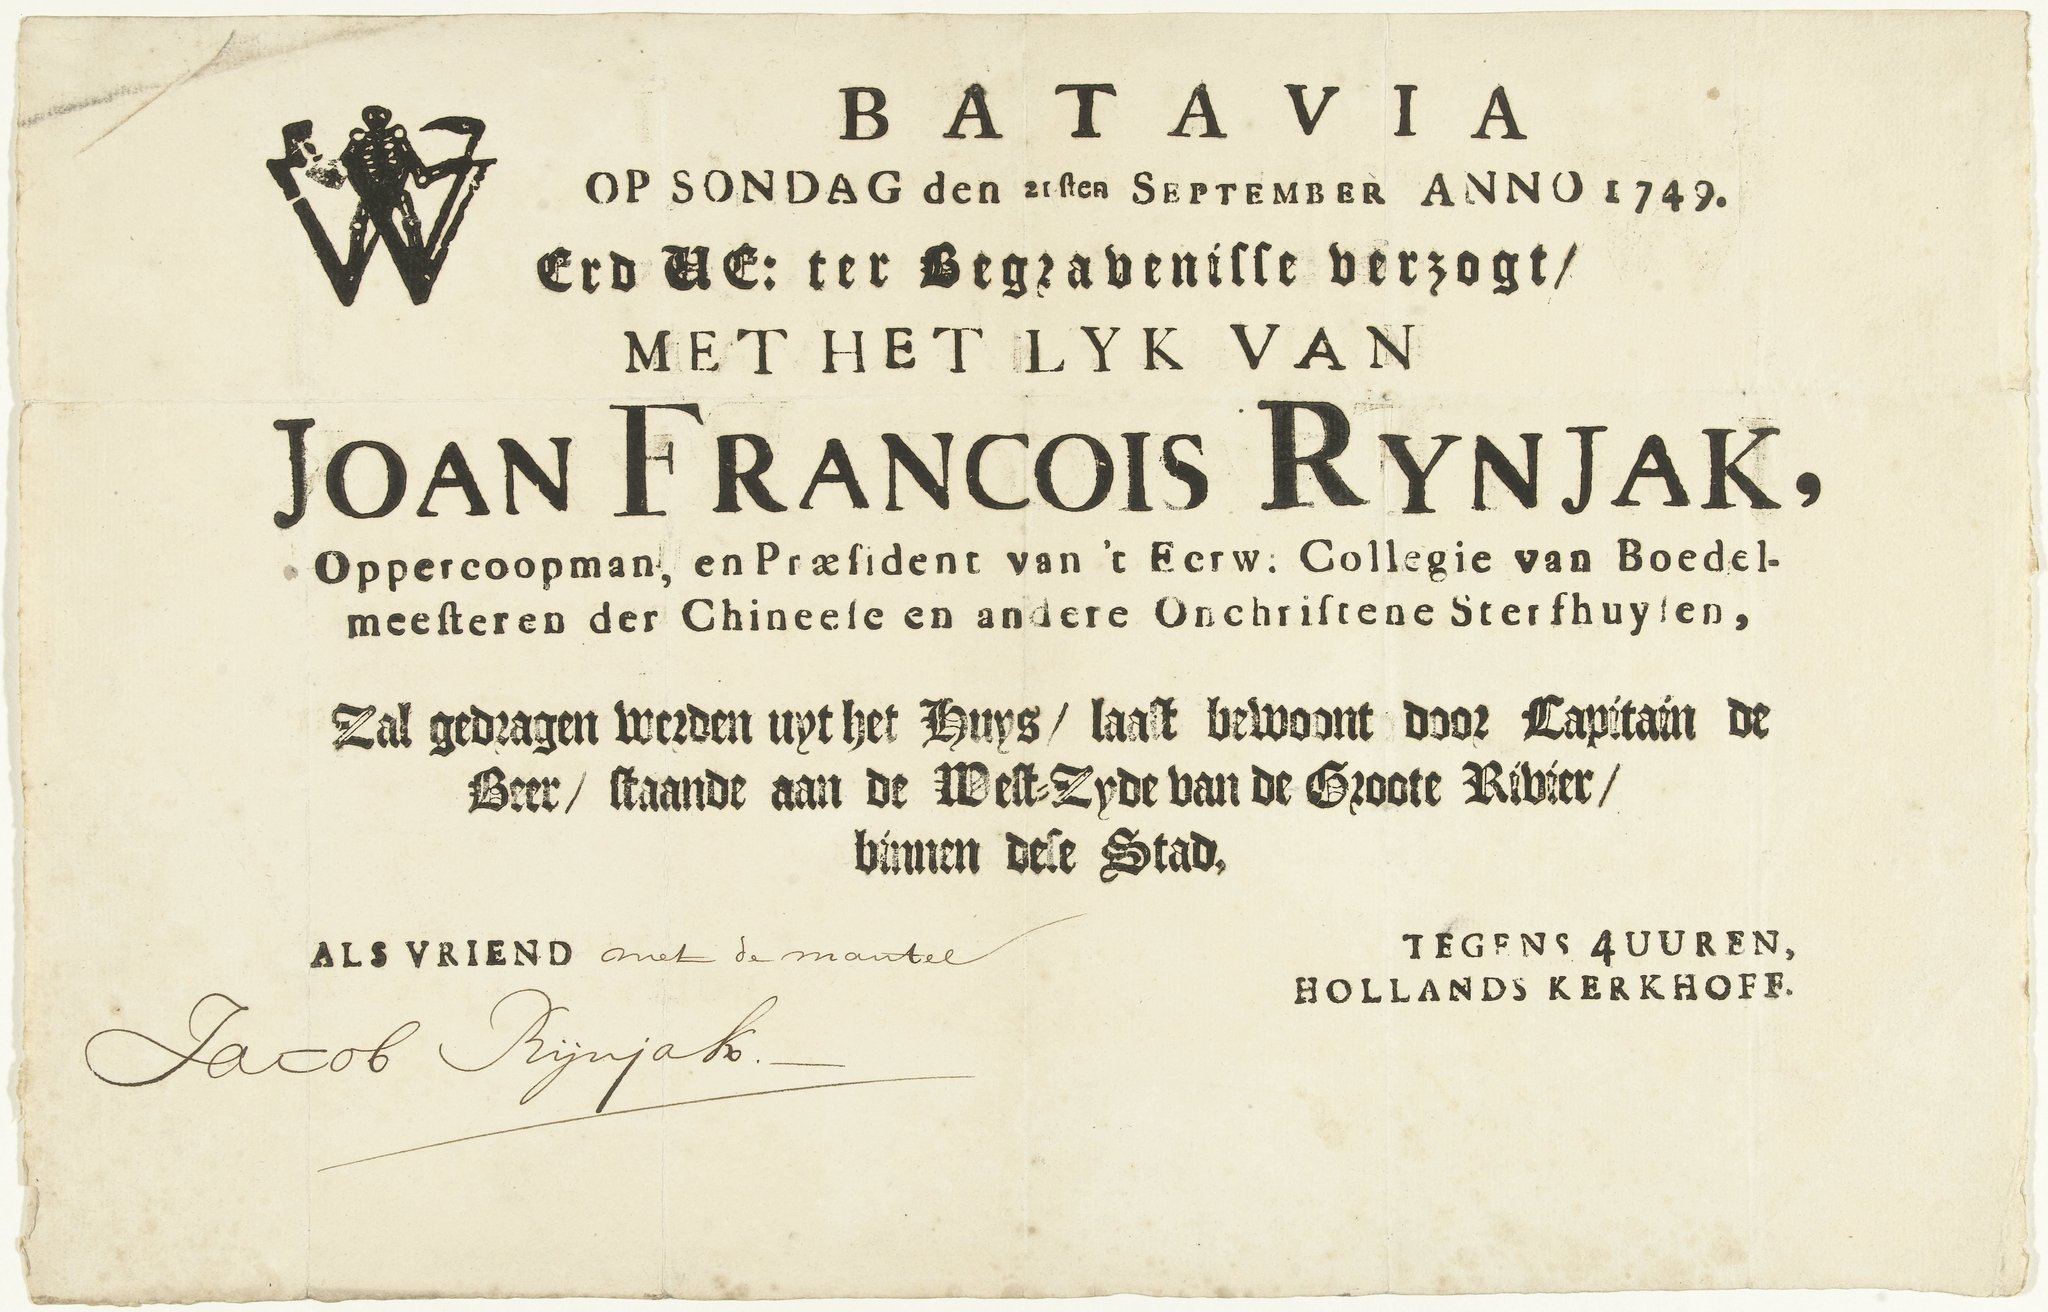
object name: invitation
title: Uitnodiging voor de begrafenis van Joan Francois Rijnjak op 21 september 1749 te Batavia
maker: Anonymous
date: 1749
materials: paper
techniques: letterpress printing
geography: batavia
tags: batavia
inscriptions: inscription: ‘met de mantel Jacob Rijnjak’, collector's mark: Lugt 2228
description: Uitnodiging voor de begrafenis van de koopman Joan Francois Rijnjak op 21 september 1749 op het Hollands Kerkhof te Batavia. De initiaal W versierd met de Dood als geraamte met zeis. Uitnodiging gericht aan Jacob Rijnjak die tijdens de begrafenis de mantel zal dragen.